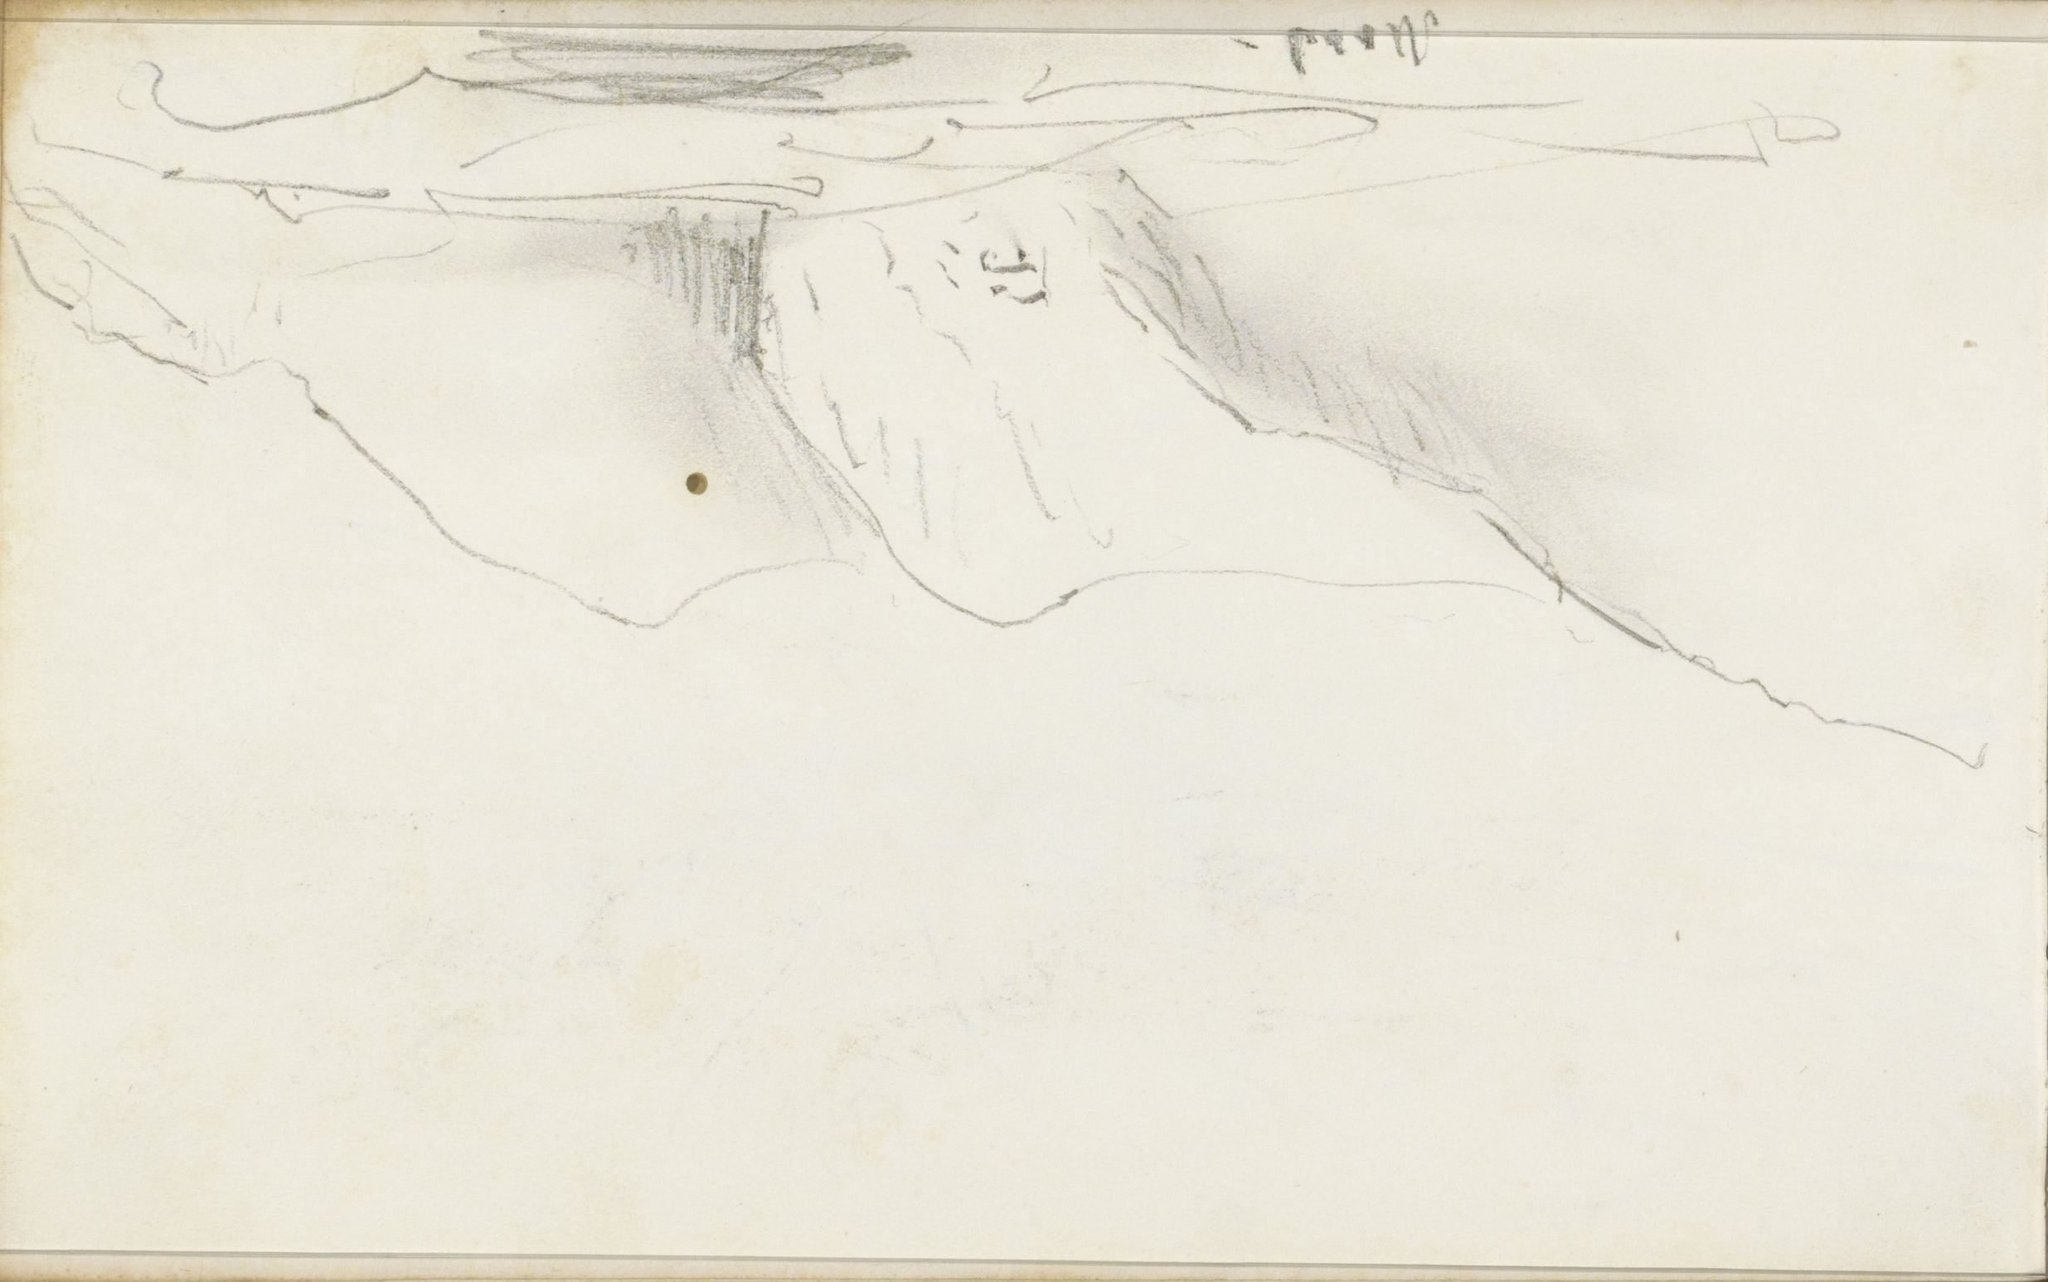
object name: sketchbook leaf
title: Bergen aan de Maas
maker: johannes tavenraat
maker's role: draughtsman, painter, print maker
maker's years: 1809-1881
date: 1840-1841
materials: paper, pencil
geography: meuse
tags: landscapes with waters, waterscapes, seascapes (in the temperate zone), mountains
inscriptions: annotation: ‘Maas’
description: Blad 16 verso uit een schetsboek met 41 bladen.